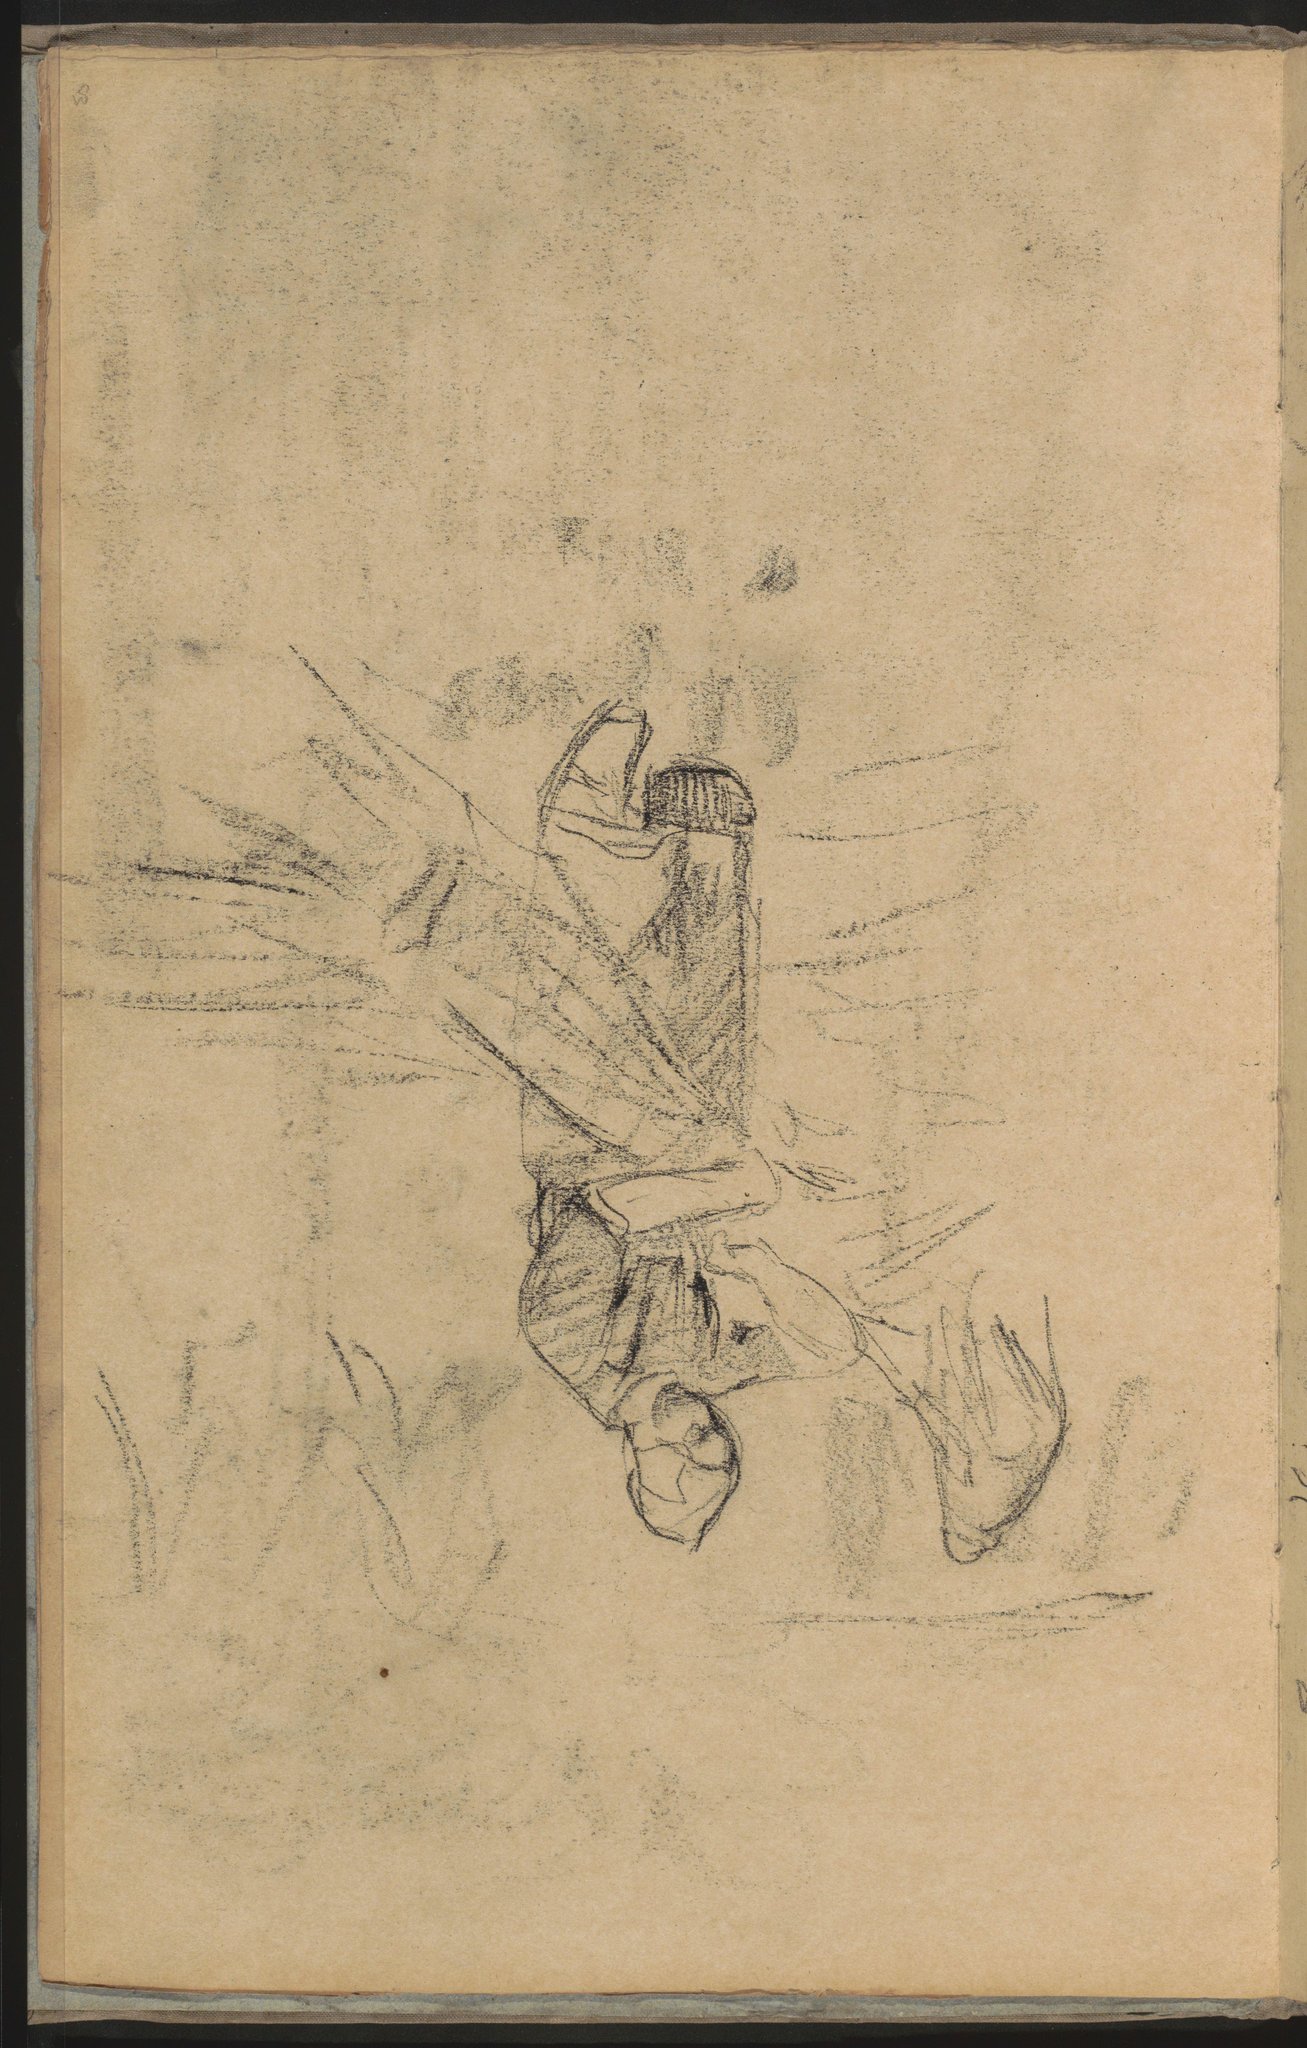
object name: sketchbook leaf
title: Vrouw die hooi of graan bundelt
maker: willem witsen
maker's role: draughtsman, painter, print maker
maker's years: 1860-1923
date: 1884-1887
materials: chalk, paper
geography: ewijkshoeve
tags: adult woman, binding ~ harvest, cultivation ~ agriculture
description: Achter haar nog een figuur op het land. Pagina 18 uit een schetsboek met 42 bladen vervaardigd rond de Ewijkshoeve.